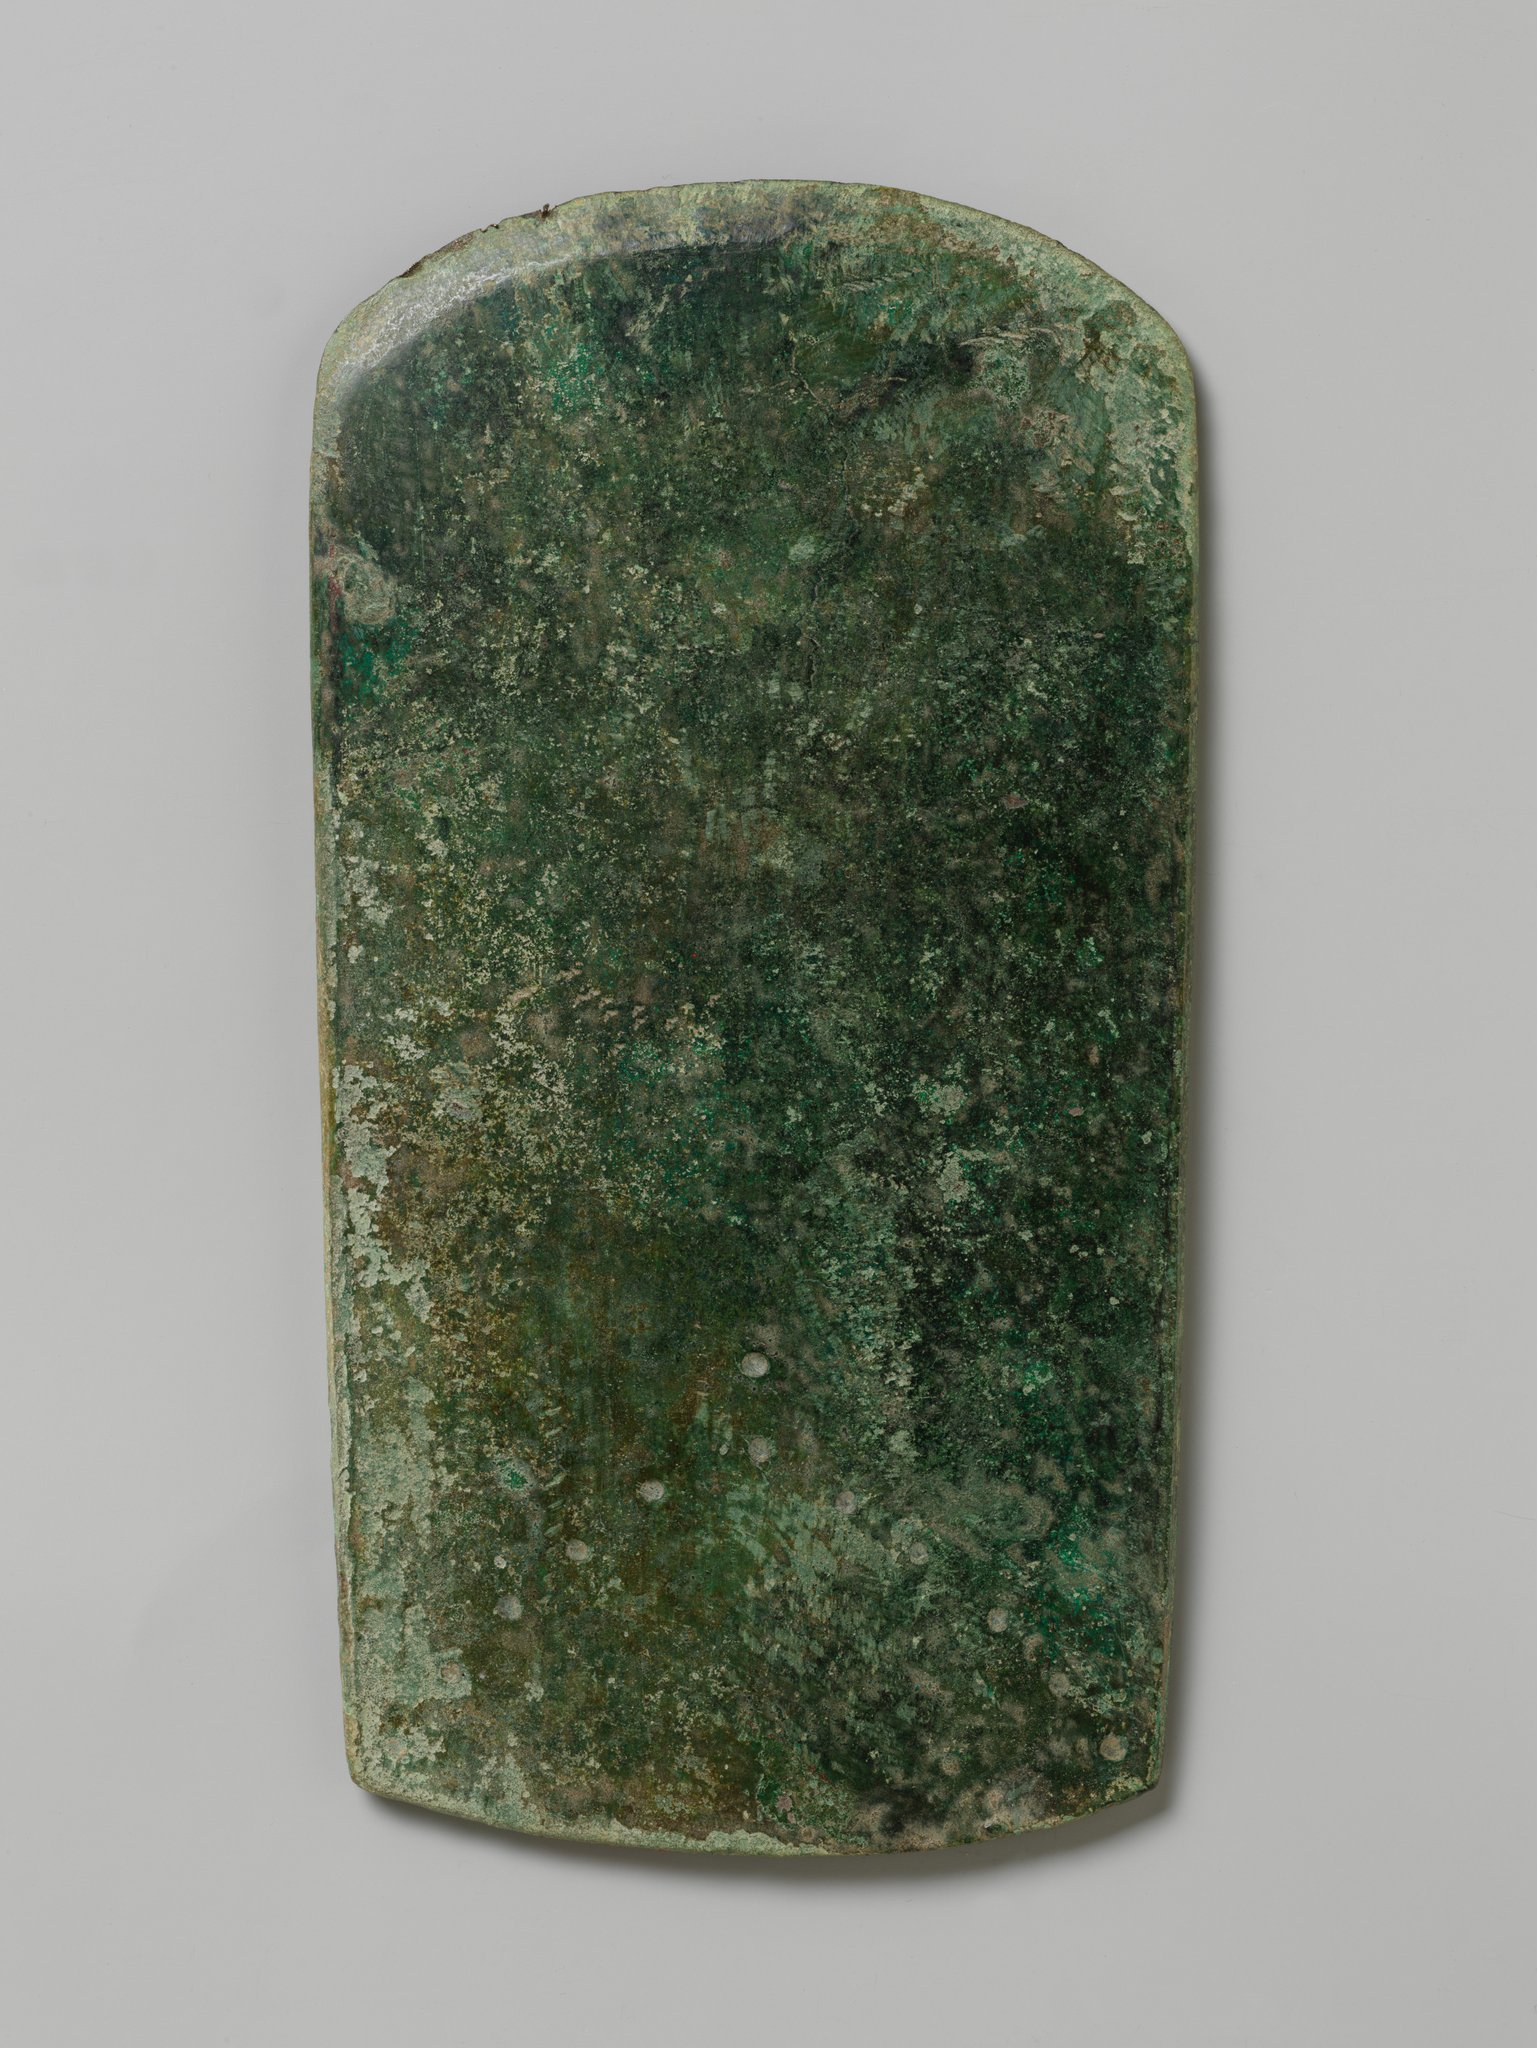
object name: ax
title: Ax with Punch Marks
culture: indian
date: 1500-1000 BCE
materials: copper